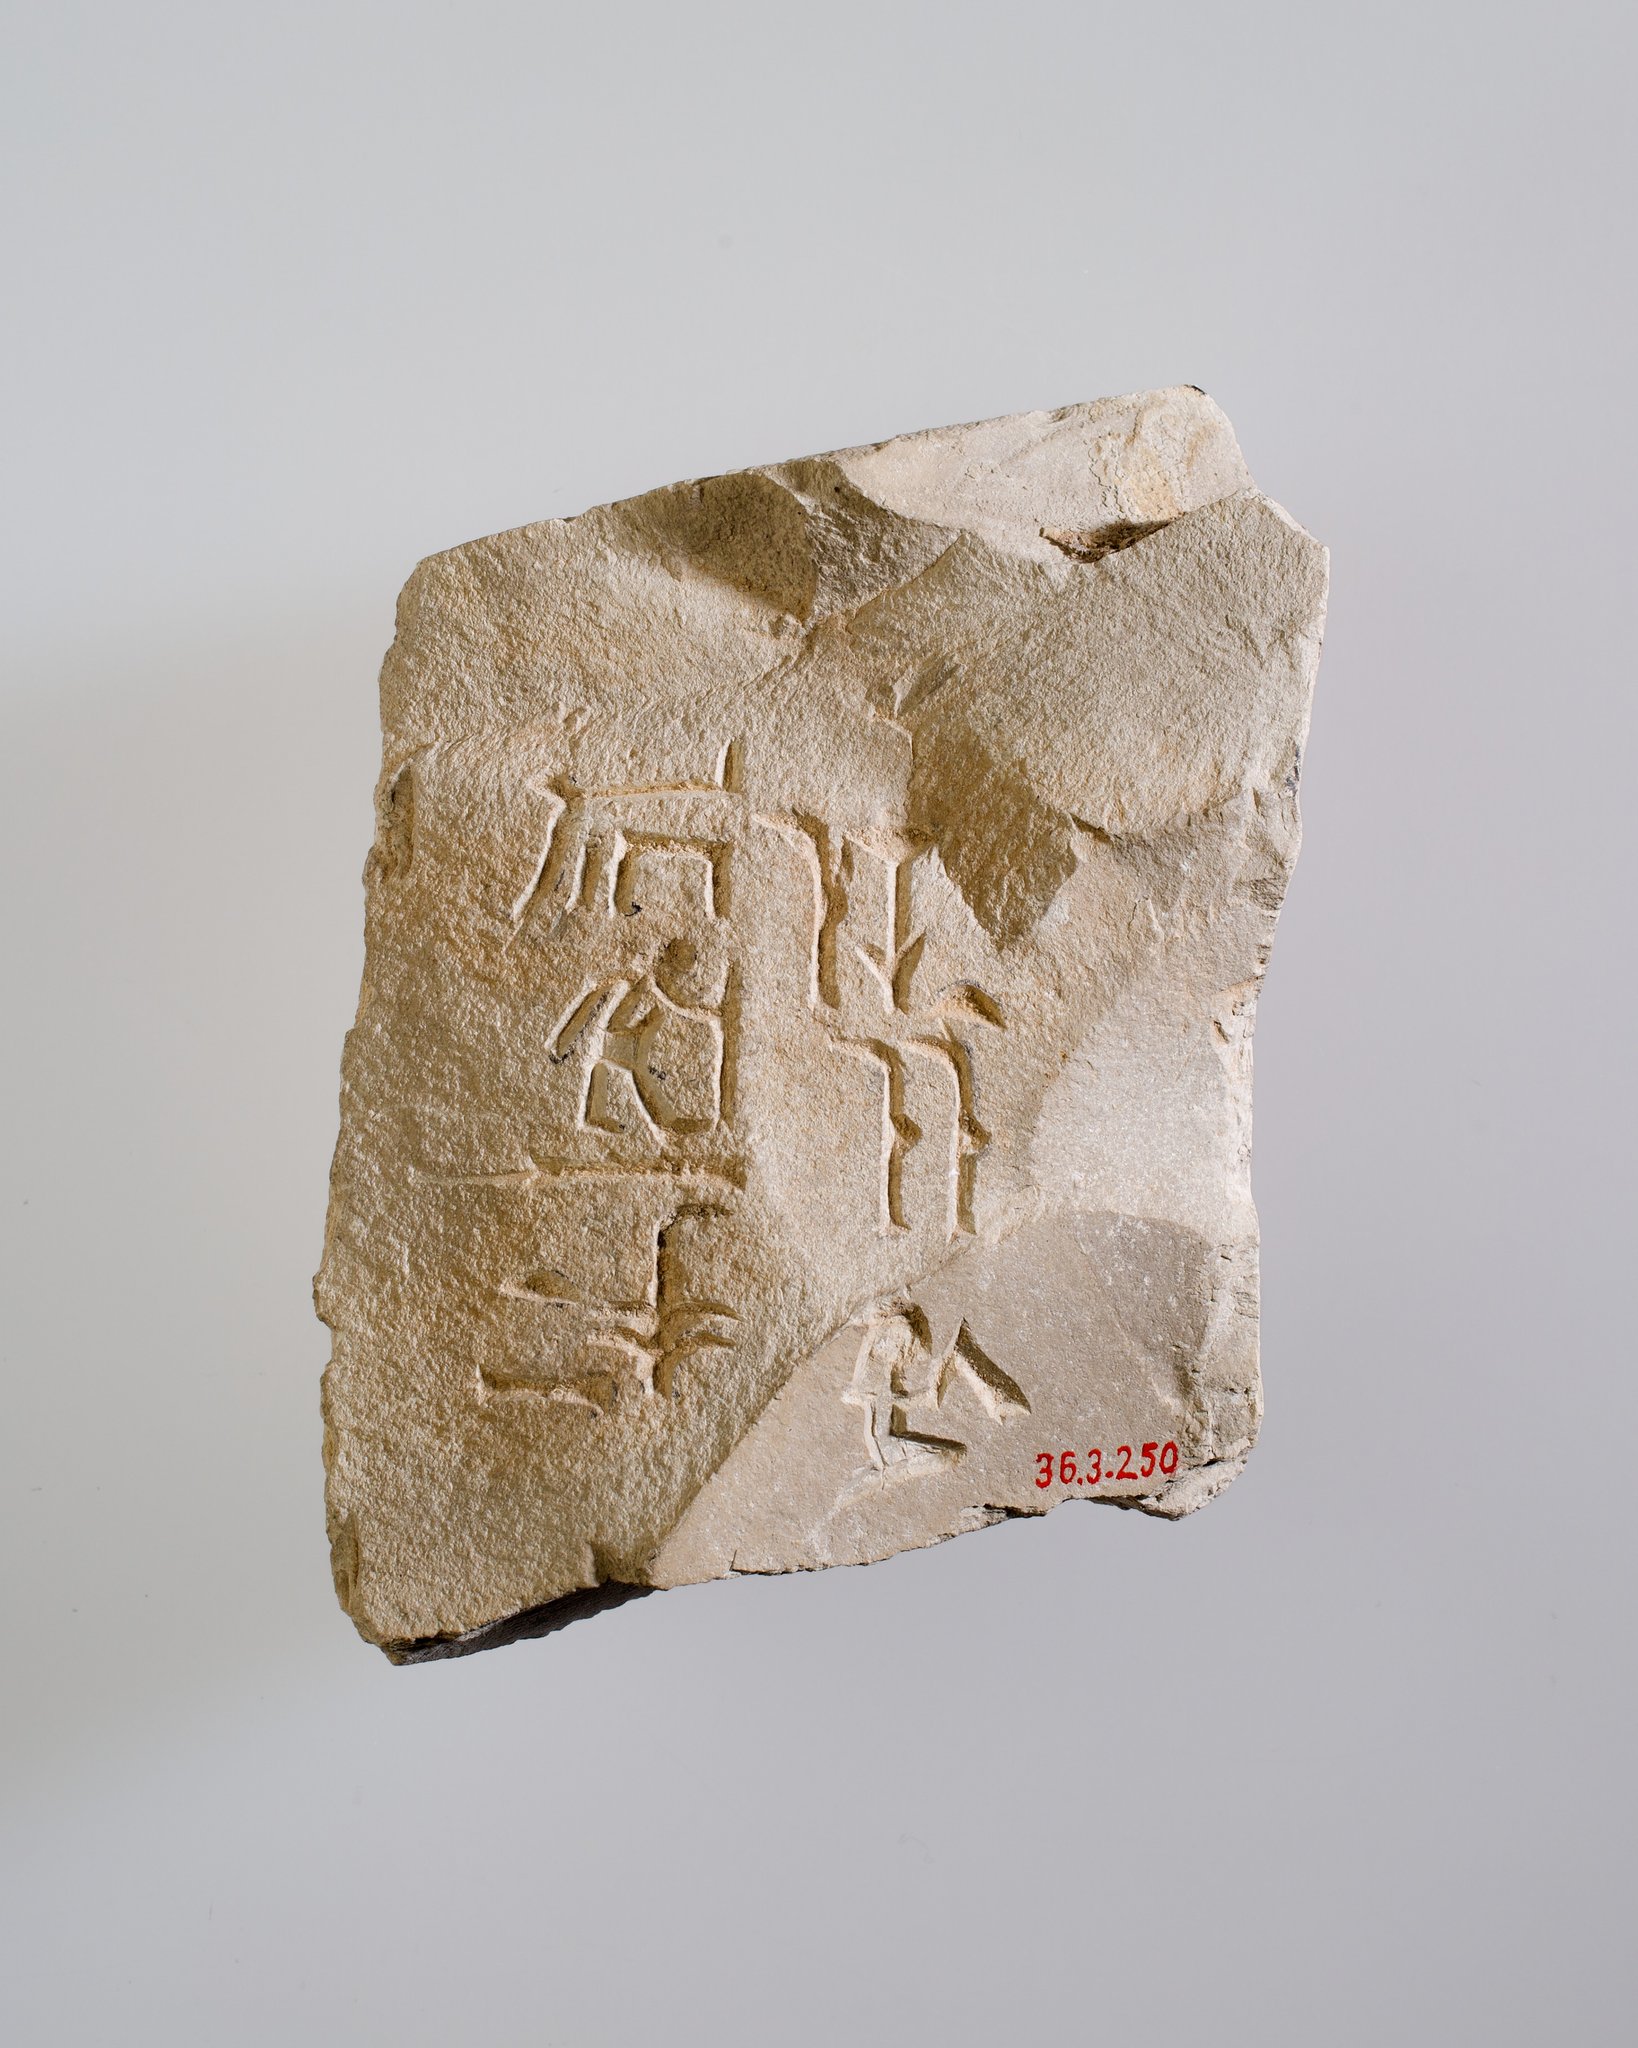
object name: name stone, tally, wadjetrenput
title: Name Stone of Wadjetrenput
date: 1479-1458 BCE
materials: limestone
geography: egypt